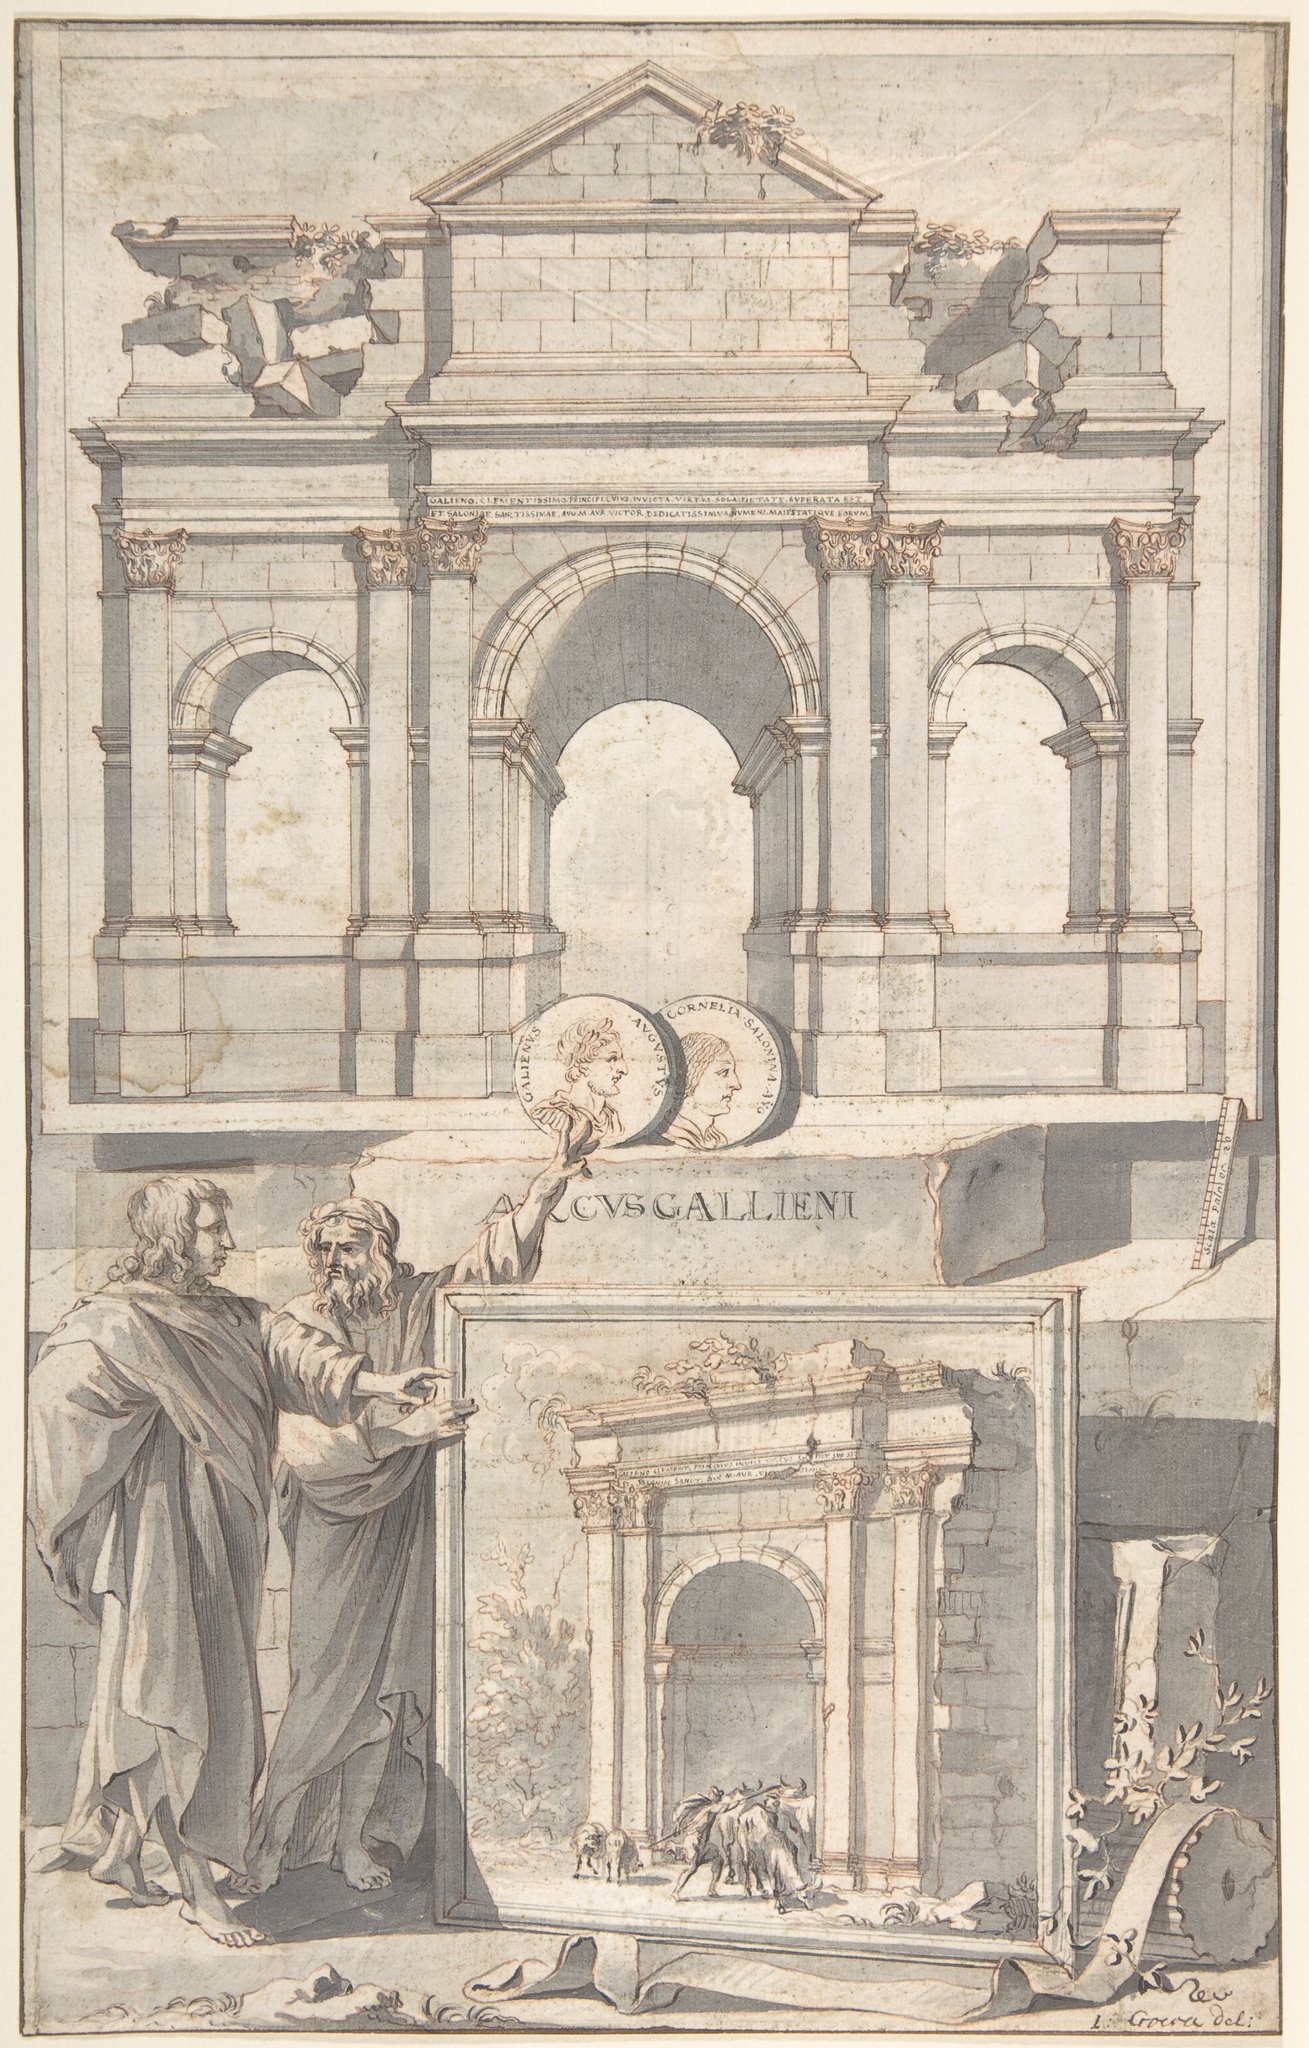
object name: drawing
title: A Reconstruction of the Arch of Gallienus (above) and a View of the Ruins (below)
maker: jan goeree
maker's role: artist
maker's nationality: dutch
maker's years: 1670-1731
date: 1704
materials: chalk, ink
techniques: brush, pen, wash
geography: italy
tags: arches,ruins,men